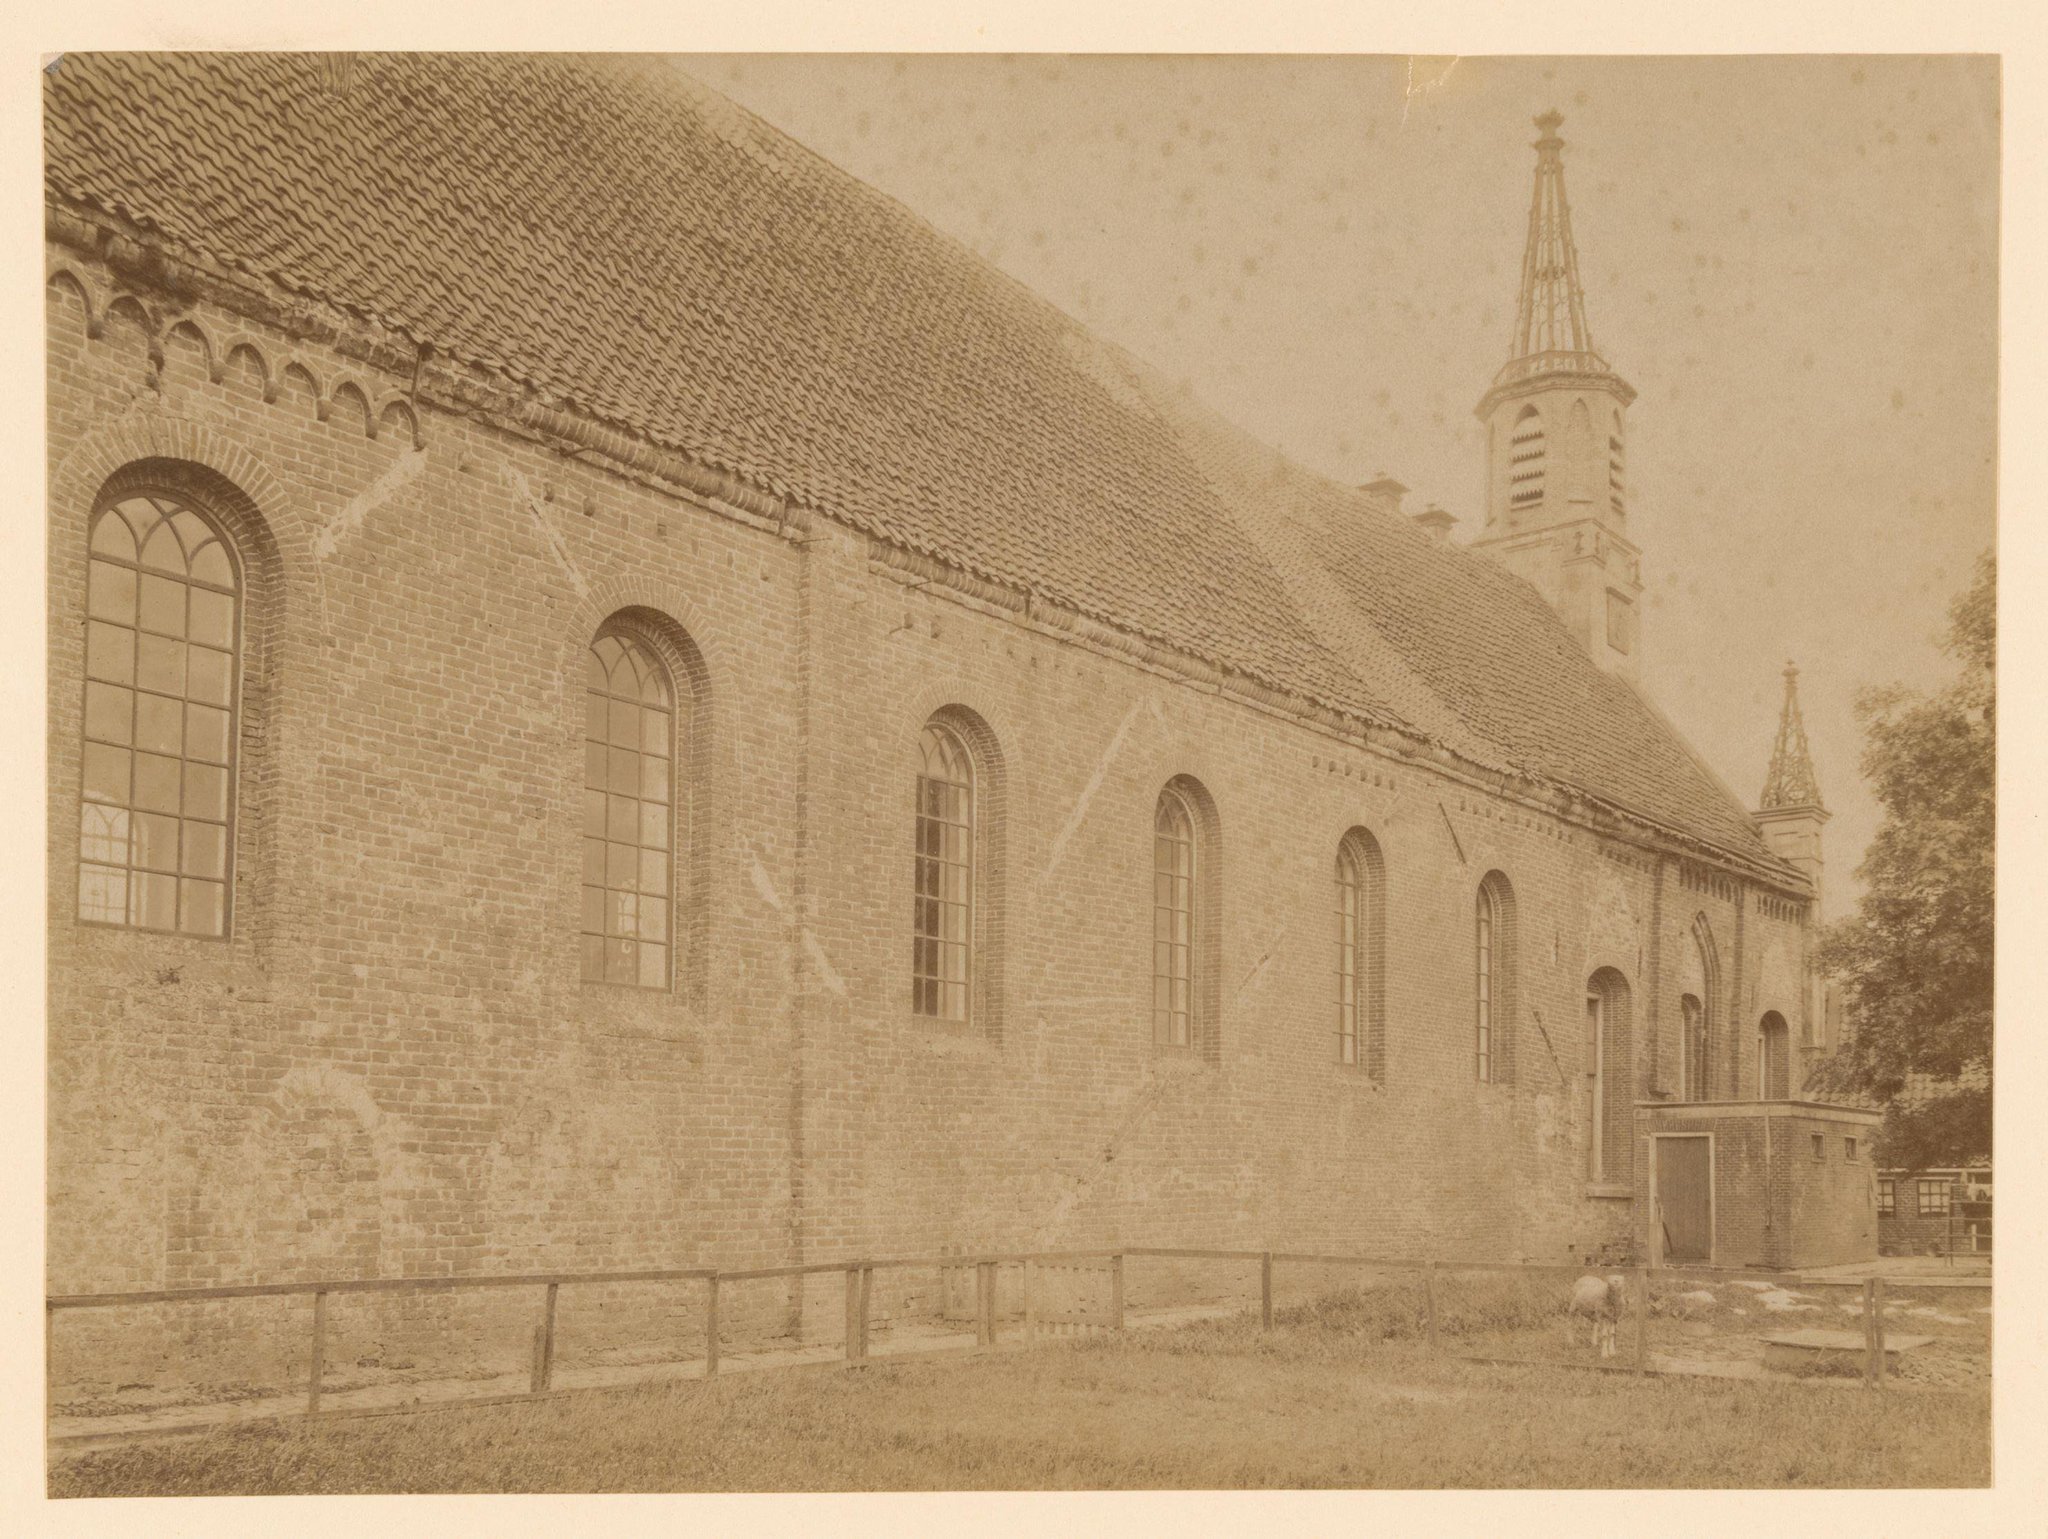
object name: photograph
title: Noordzijde van de abdijkerk te Aduard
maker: anoniem (monumentenzorg)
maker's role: fotograaf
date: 1900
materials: cardboard, photographic support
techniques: albumen print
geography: aduard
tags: church (exterior)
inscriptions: annotation: ‘Aduard’, annotation: ‘Aduard noordzijde der N.H. kerk/ juni 1900’